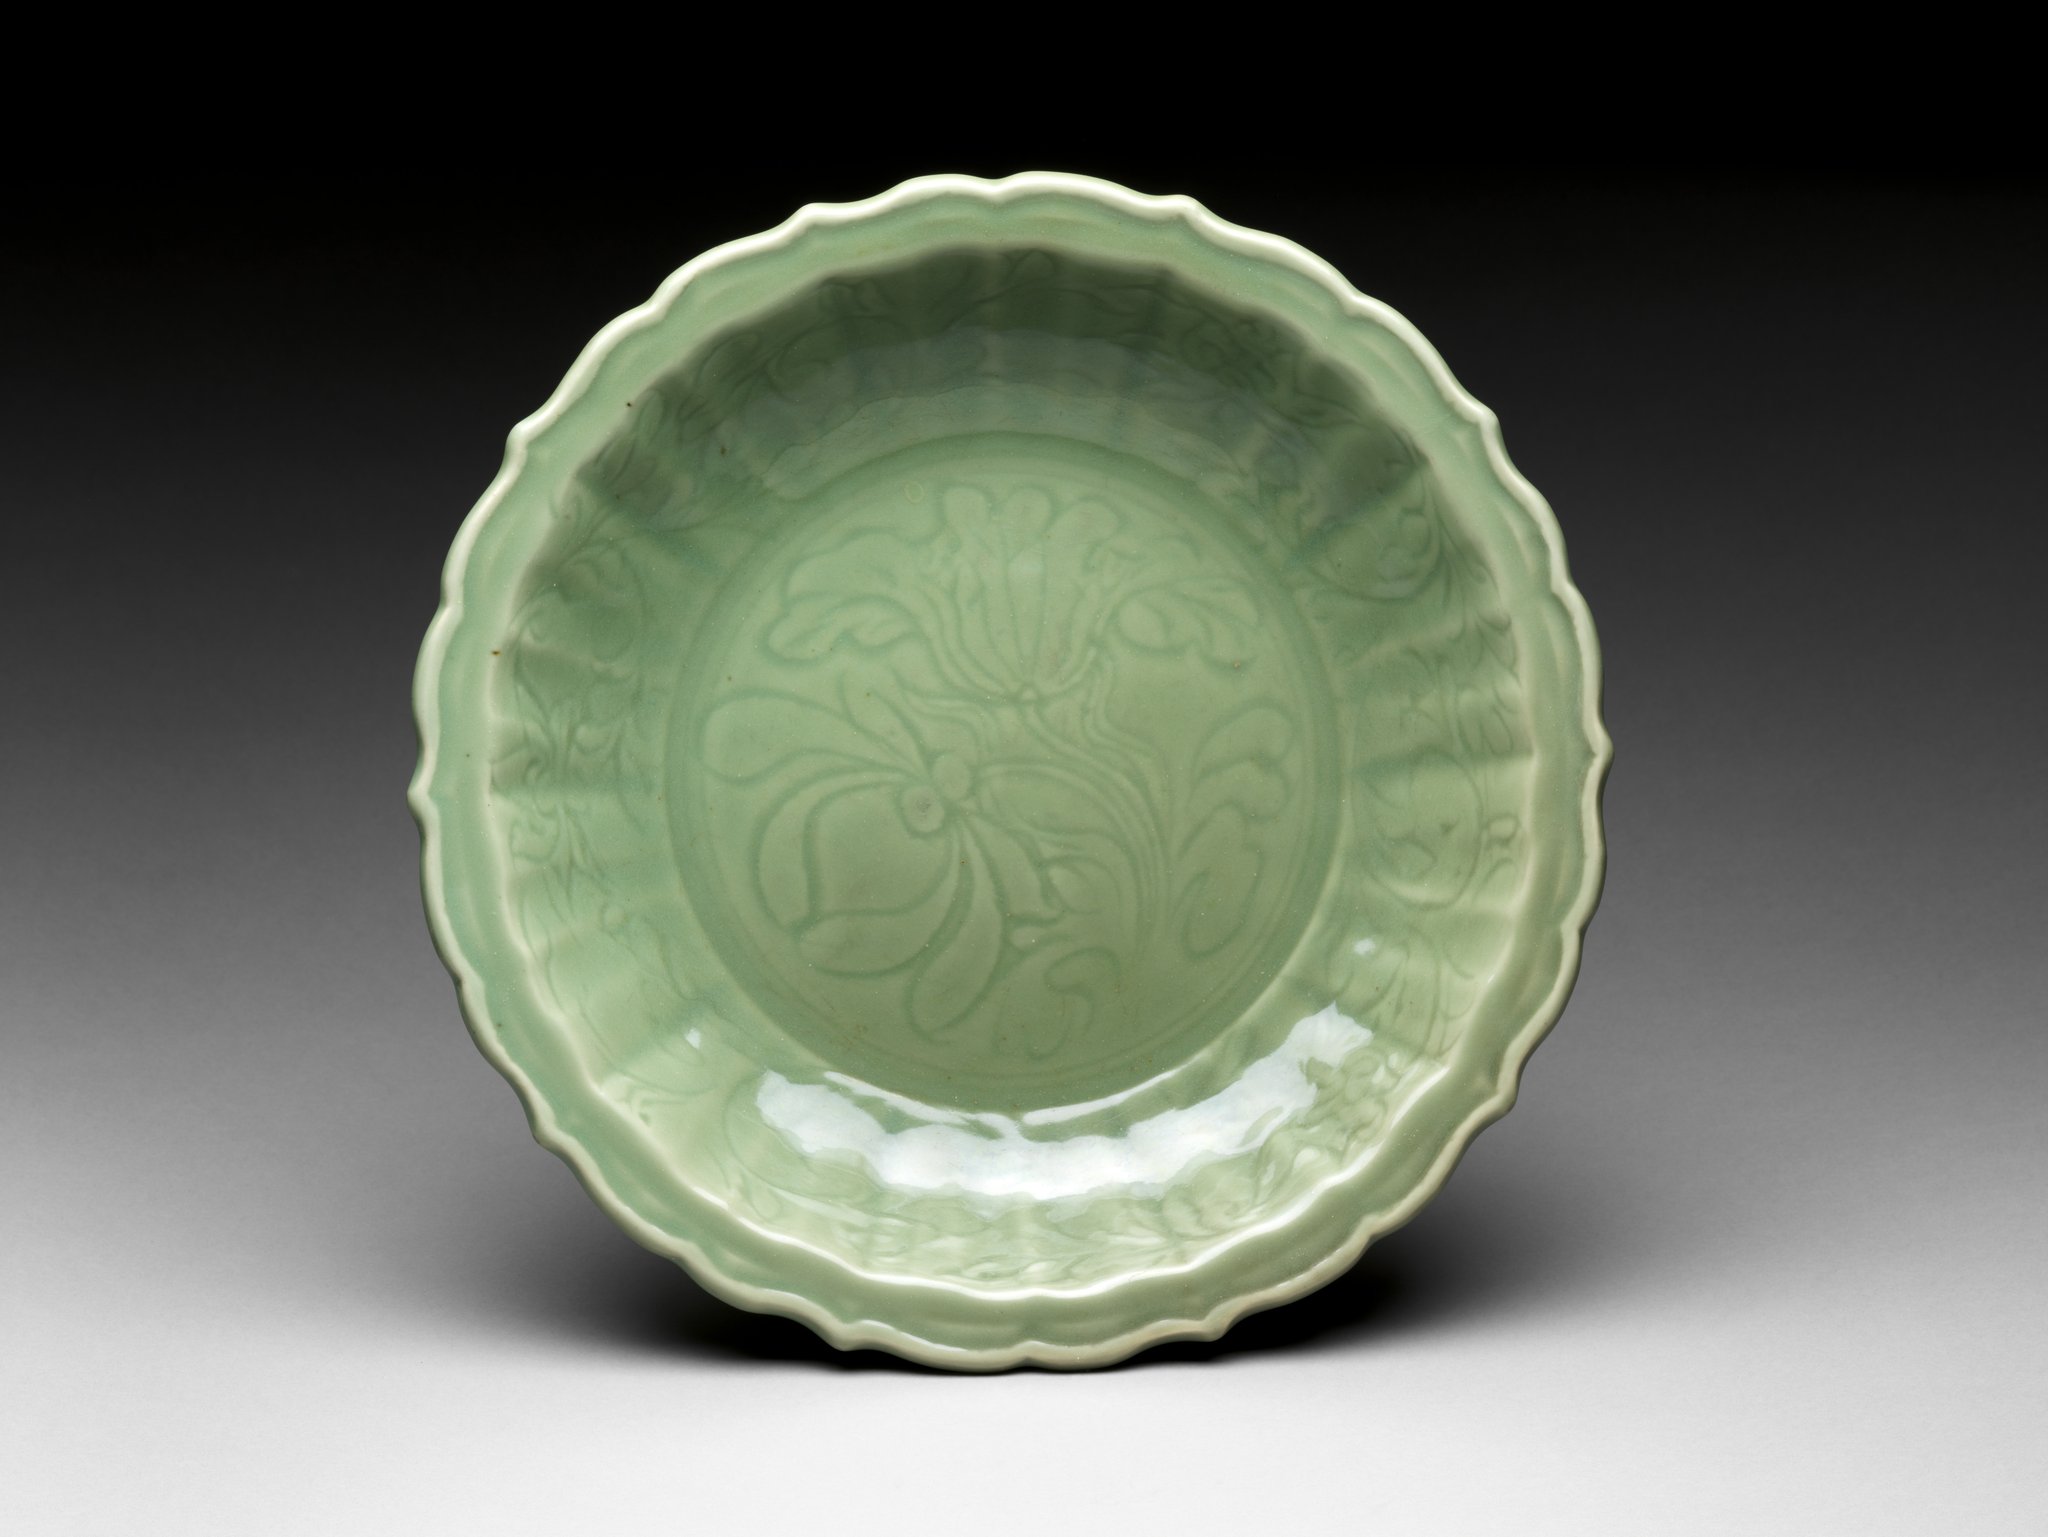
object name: plate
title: Plate with Lotus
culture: chinese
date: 1401-1500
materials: ceramic glaze, glaze, porcelain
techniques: incising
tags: lotuses,leaves